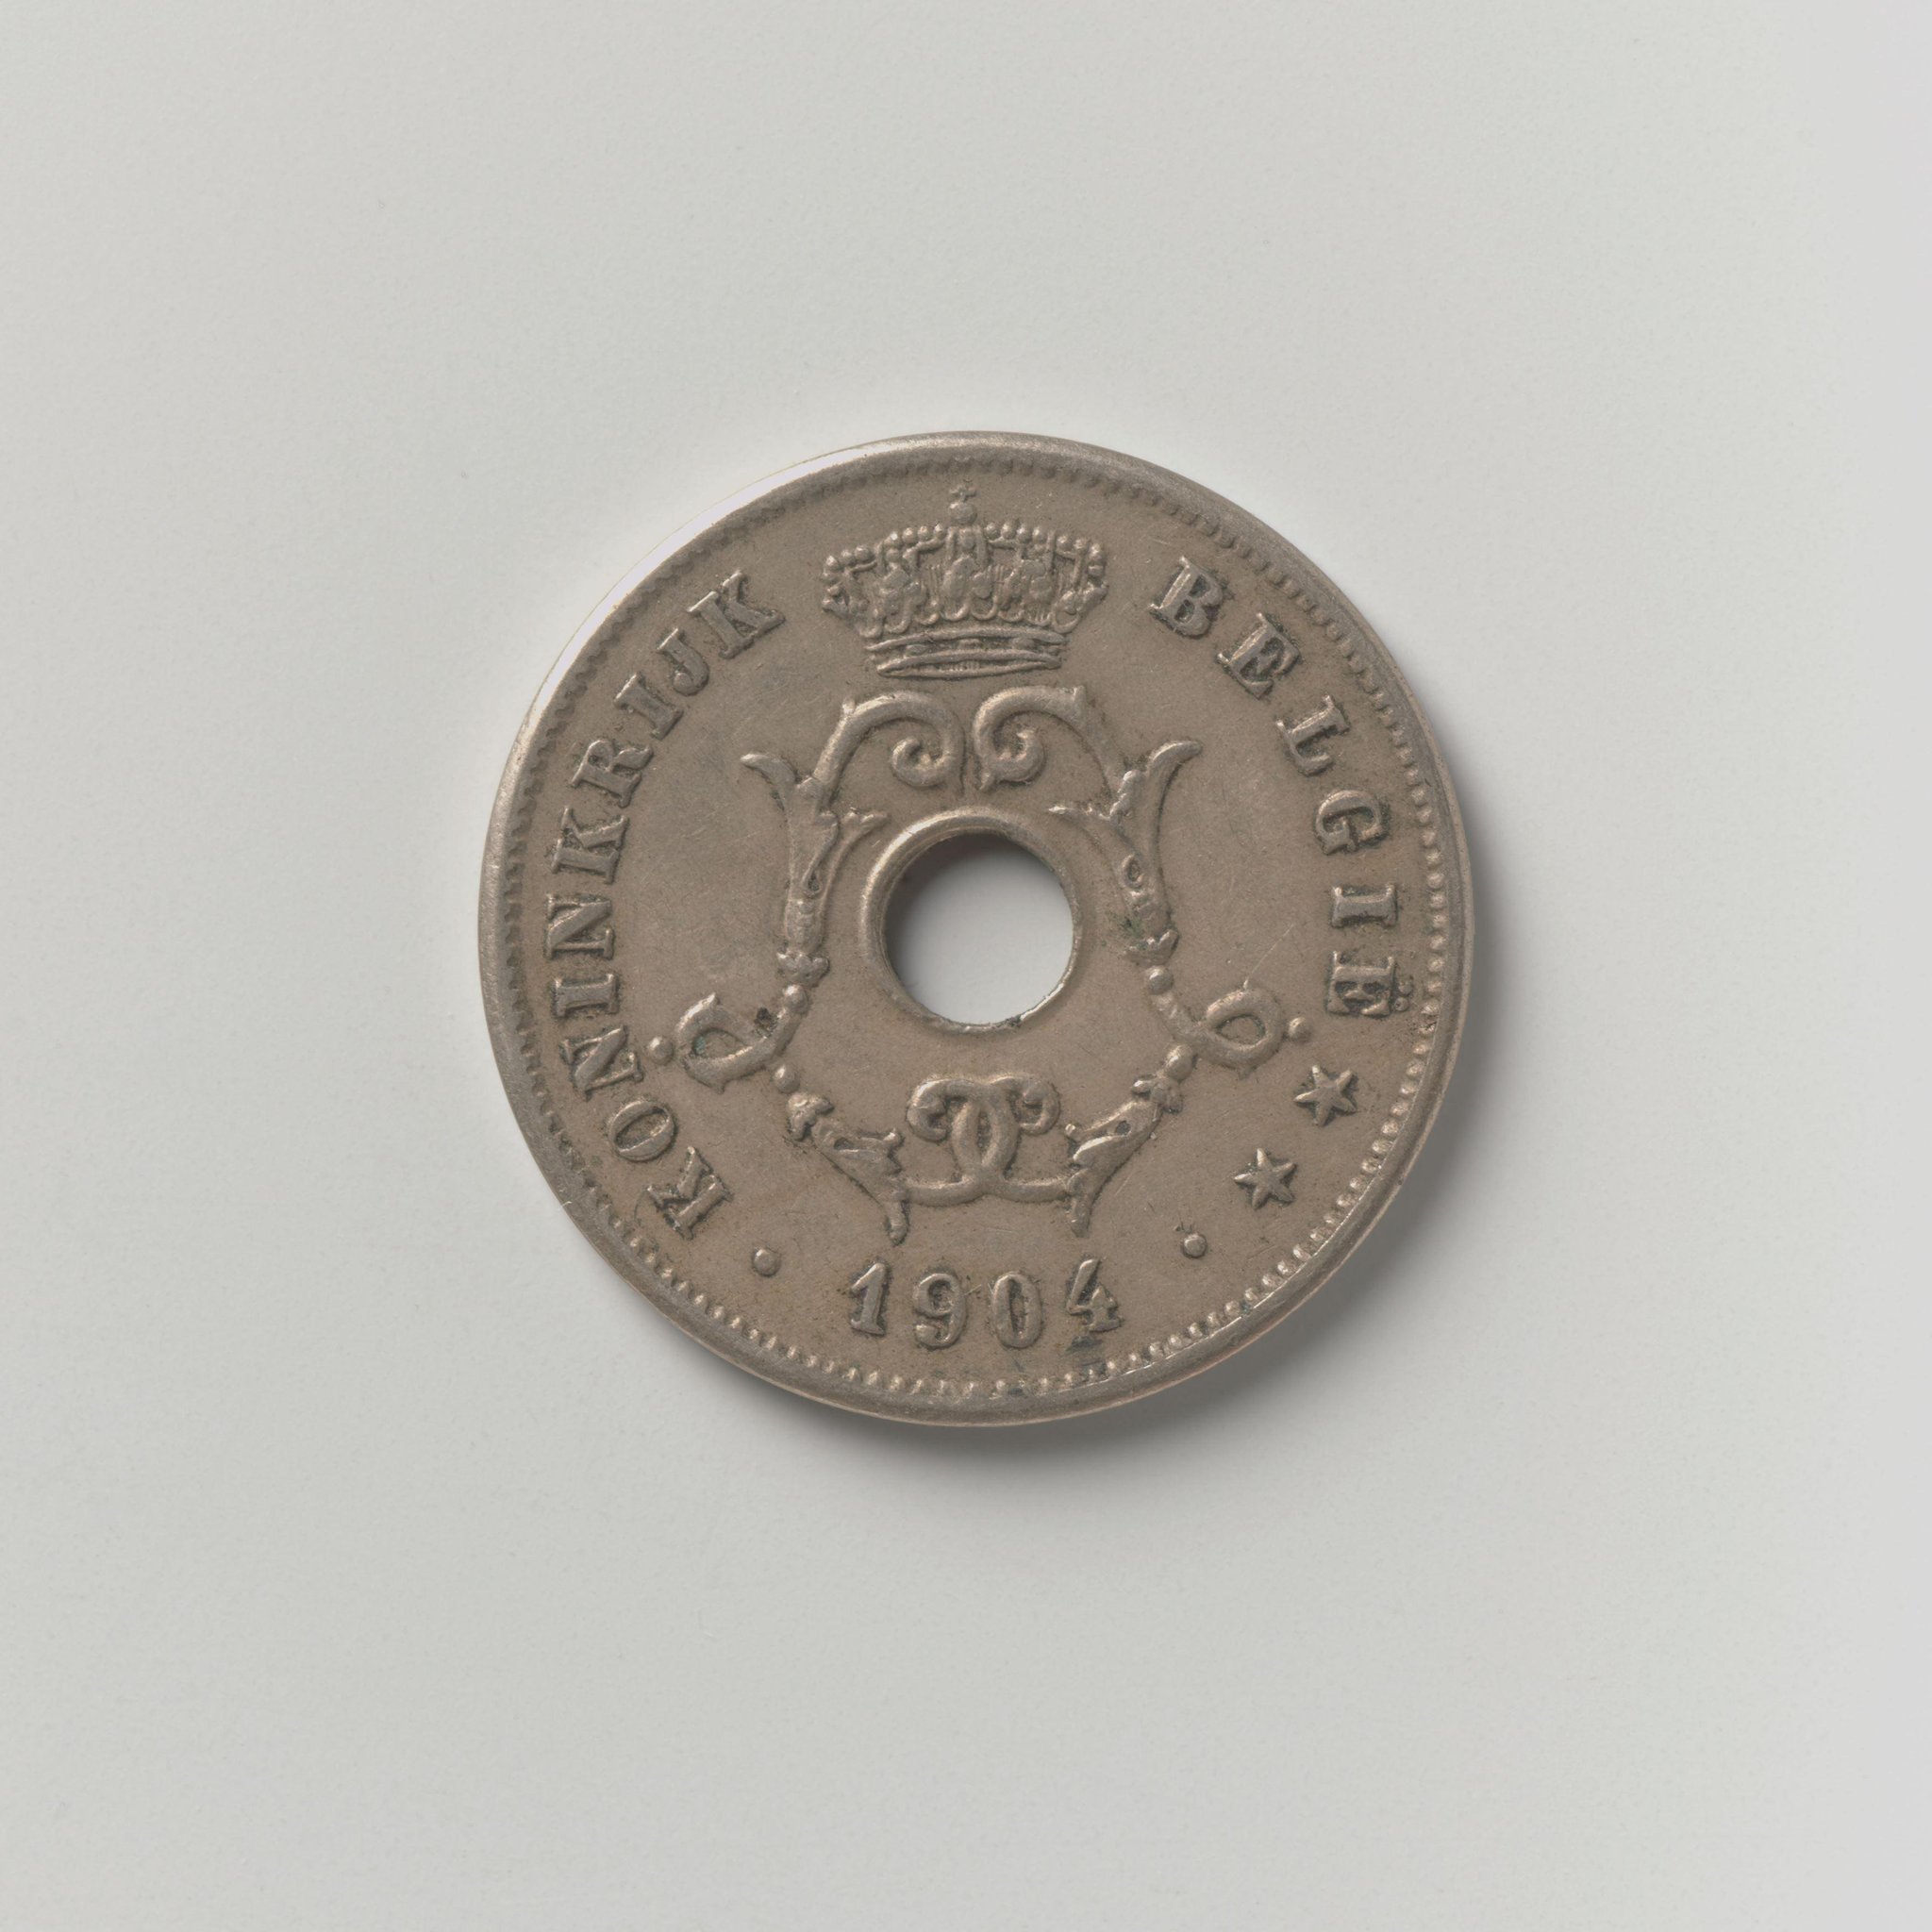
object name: coin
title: 10 centiemen uit België van Leopold II, 1904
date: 1904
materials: nickel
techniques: striking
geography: brussels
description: Nikkelen munt. Voorzijde: gekroond monogram van twee letters L. Jaaartal onderaan. Keerzijde: rechts van gebogen lauwertak waarde-aanduiding 10 Cen. Centrale doorboring. Gladde rand.